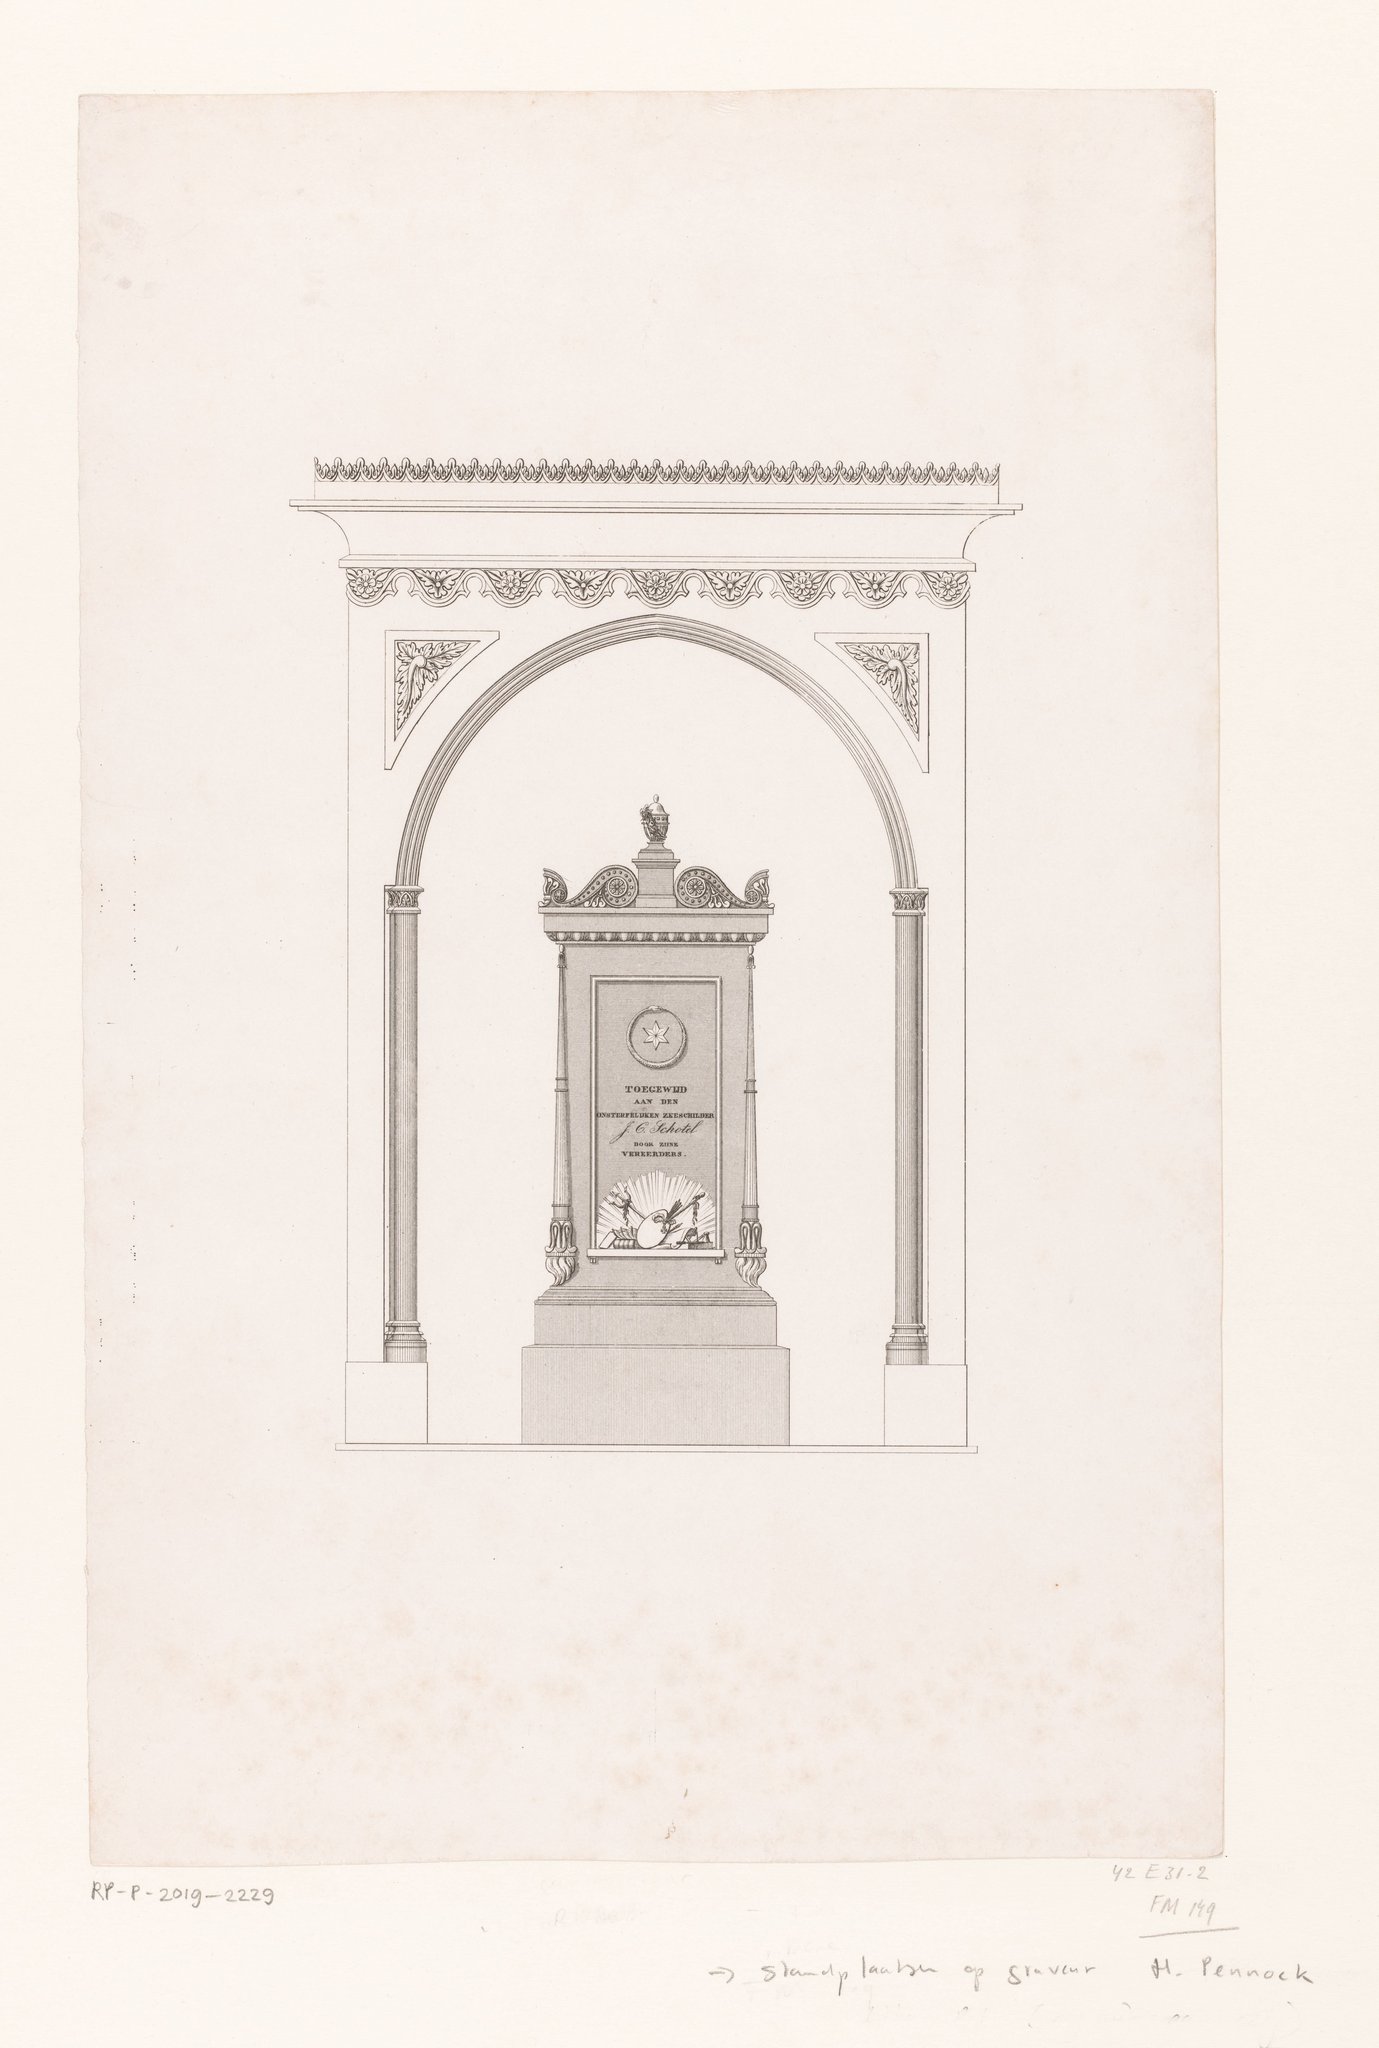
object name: print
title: Monument ter nagedachtenis aan de schilder Johannes Christiaan Schotel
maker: hendrikus pennock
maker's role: print maker, printer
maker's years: 1814-1848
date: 1839-1842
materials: paper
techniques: lithograph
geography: dordrecht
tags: painter, draughtsman, johannes christiaan schotel, grave-building, monumental tomb, epitaph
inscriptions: collector's mark: Lugt 2228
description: Bouwkundige afbeelding van het monument opgericht in de Grote Kerk te Dordrecht ter nagedachtenis aan de zeeschilder Johannes Christiaan Schotel, overleden op 21 december 1838.